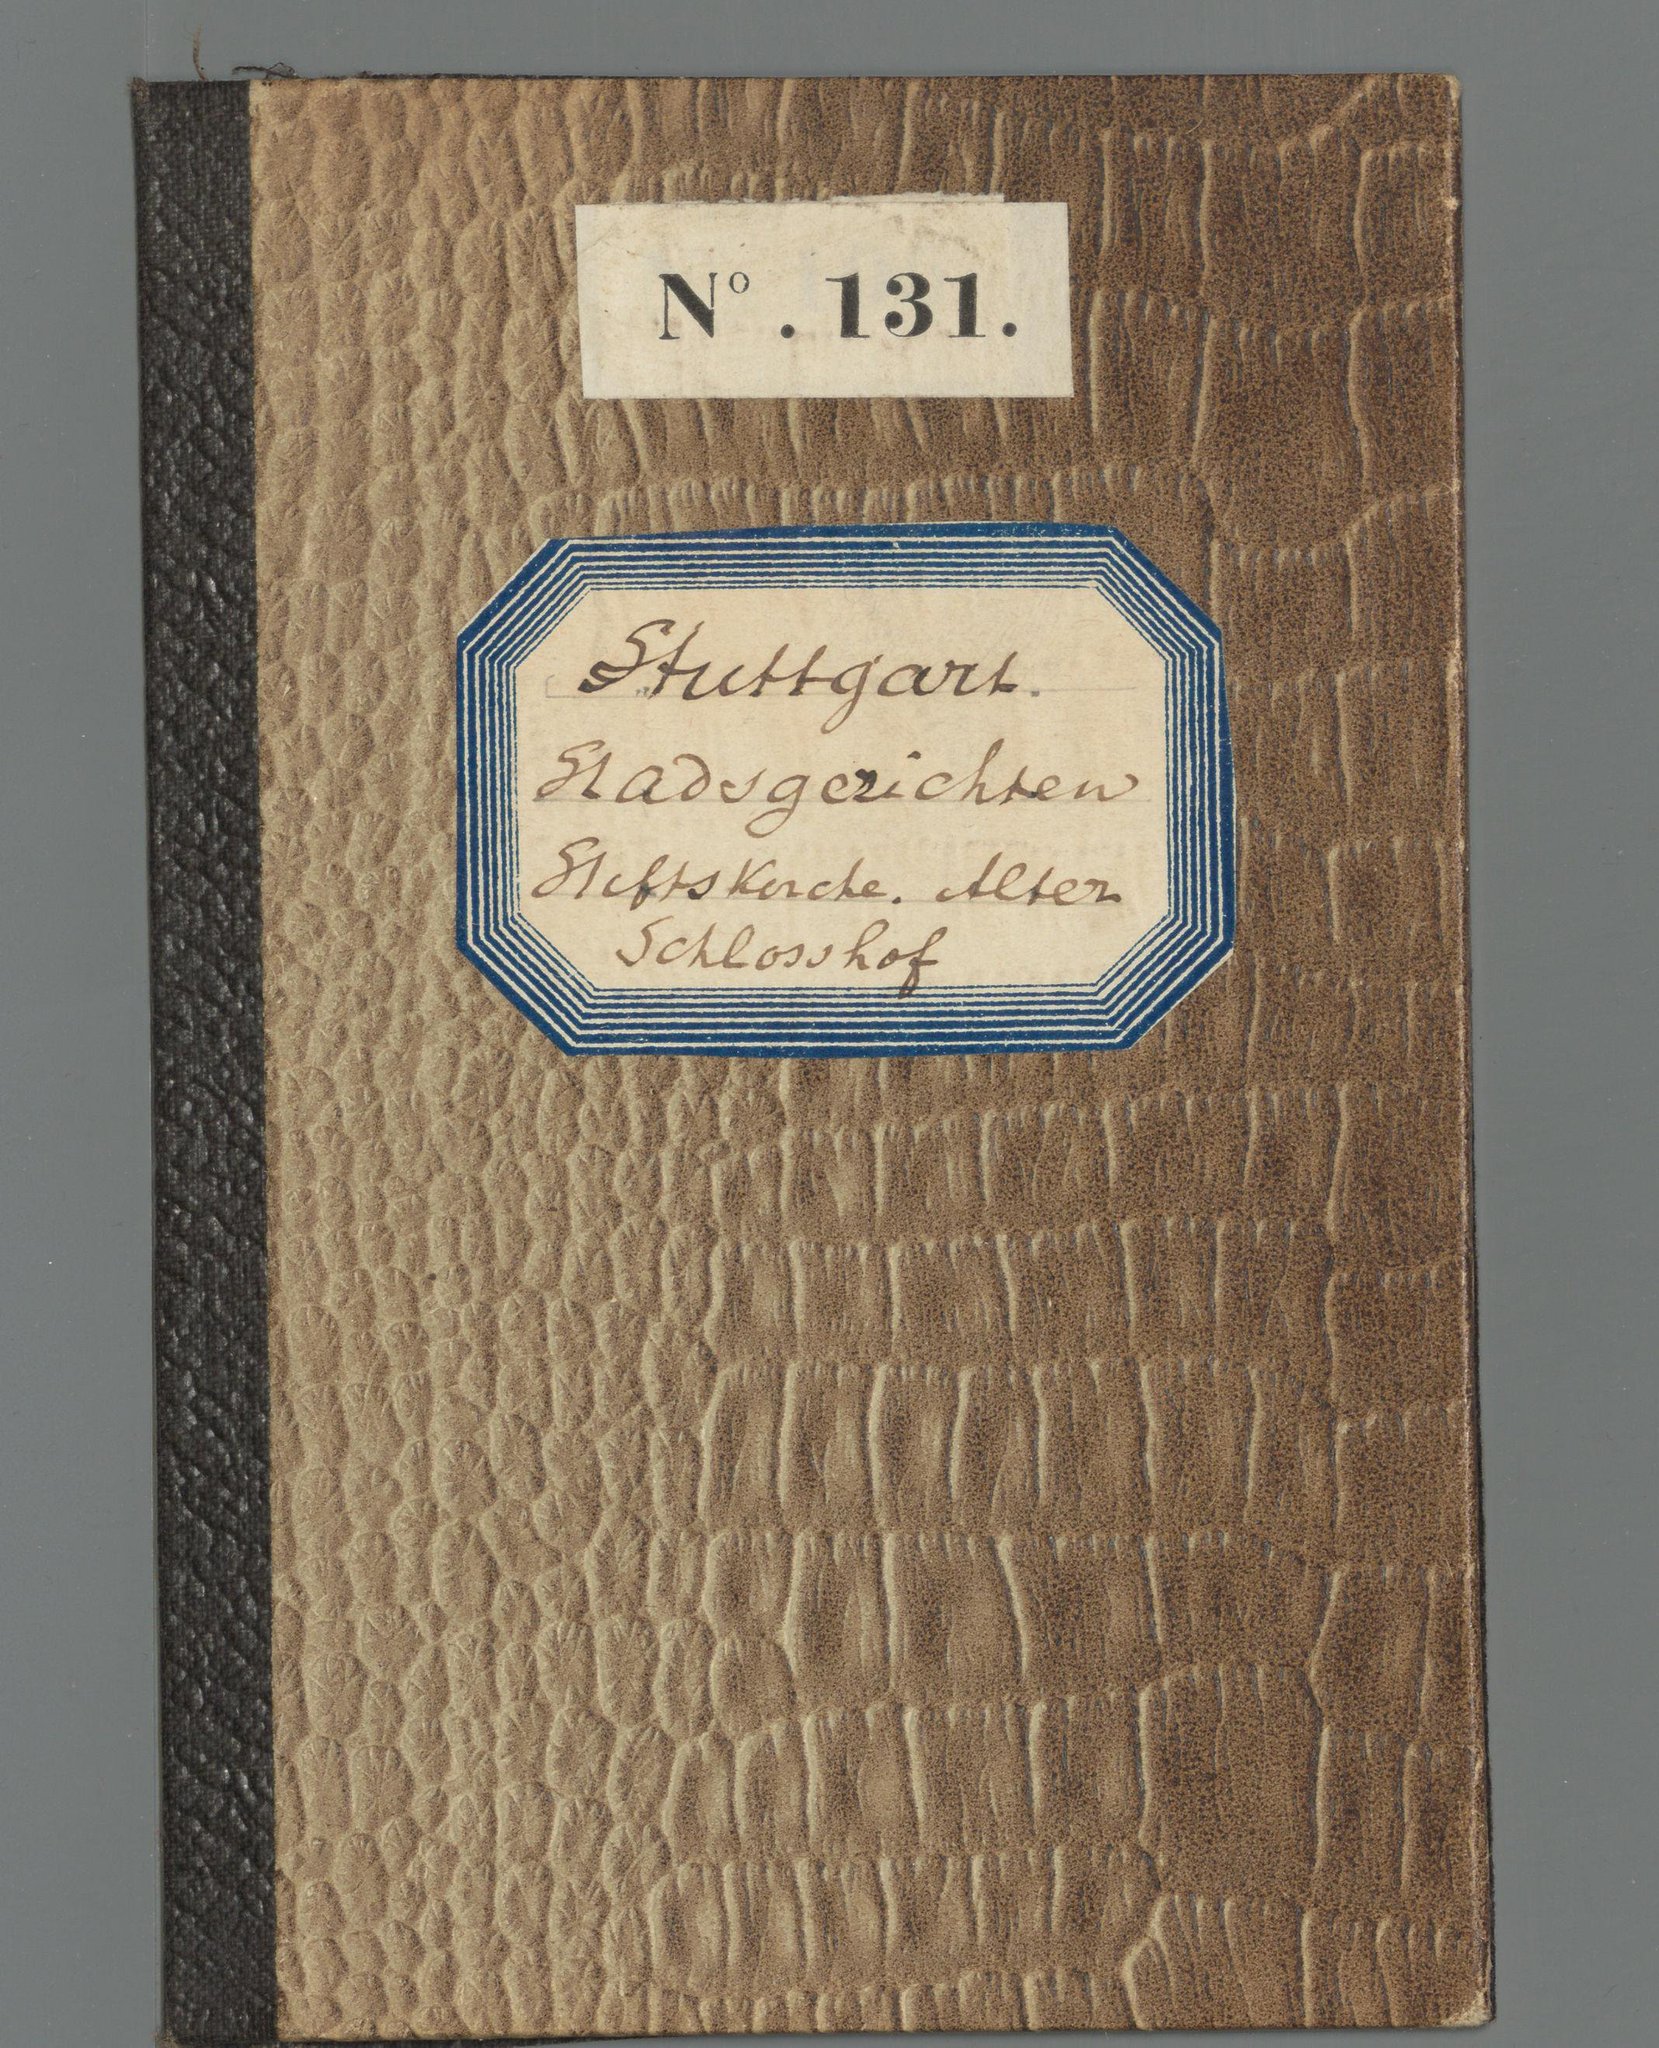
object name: wrapper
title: Omslag voor 23 prentbriefkaarten met stadsgezichten uit Stuttgart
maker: Anonymous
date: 1900-1950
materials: cardboard, paper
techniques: lithograph, writing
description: In de omslag zit een kaart ingestoken met daarop een korte beschrijving van de inhoud.